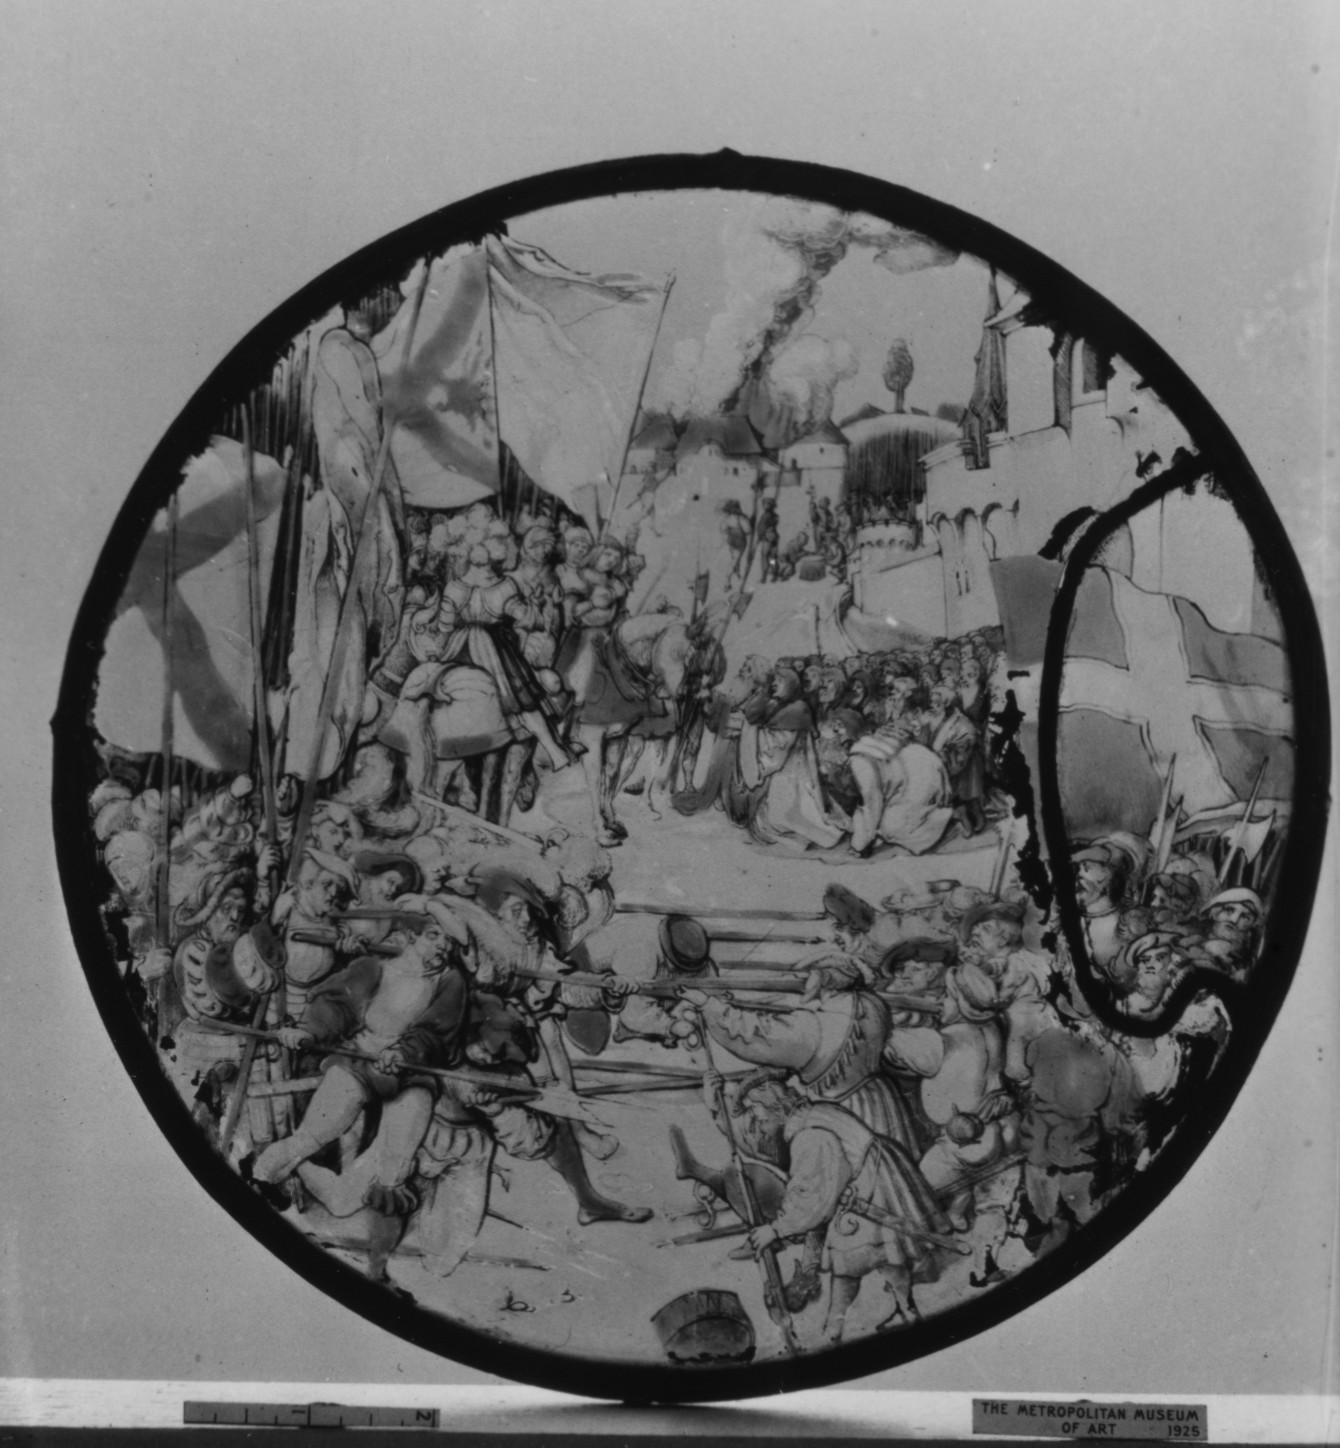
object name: roundel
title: The Campaign of the Emperor Maximilian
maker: jörg breu the elder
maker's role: designer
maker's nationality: german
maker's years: 1480-1537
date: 1515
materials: glass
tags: firearms,men,flags